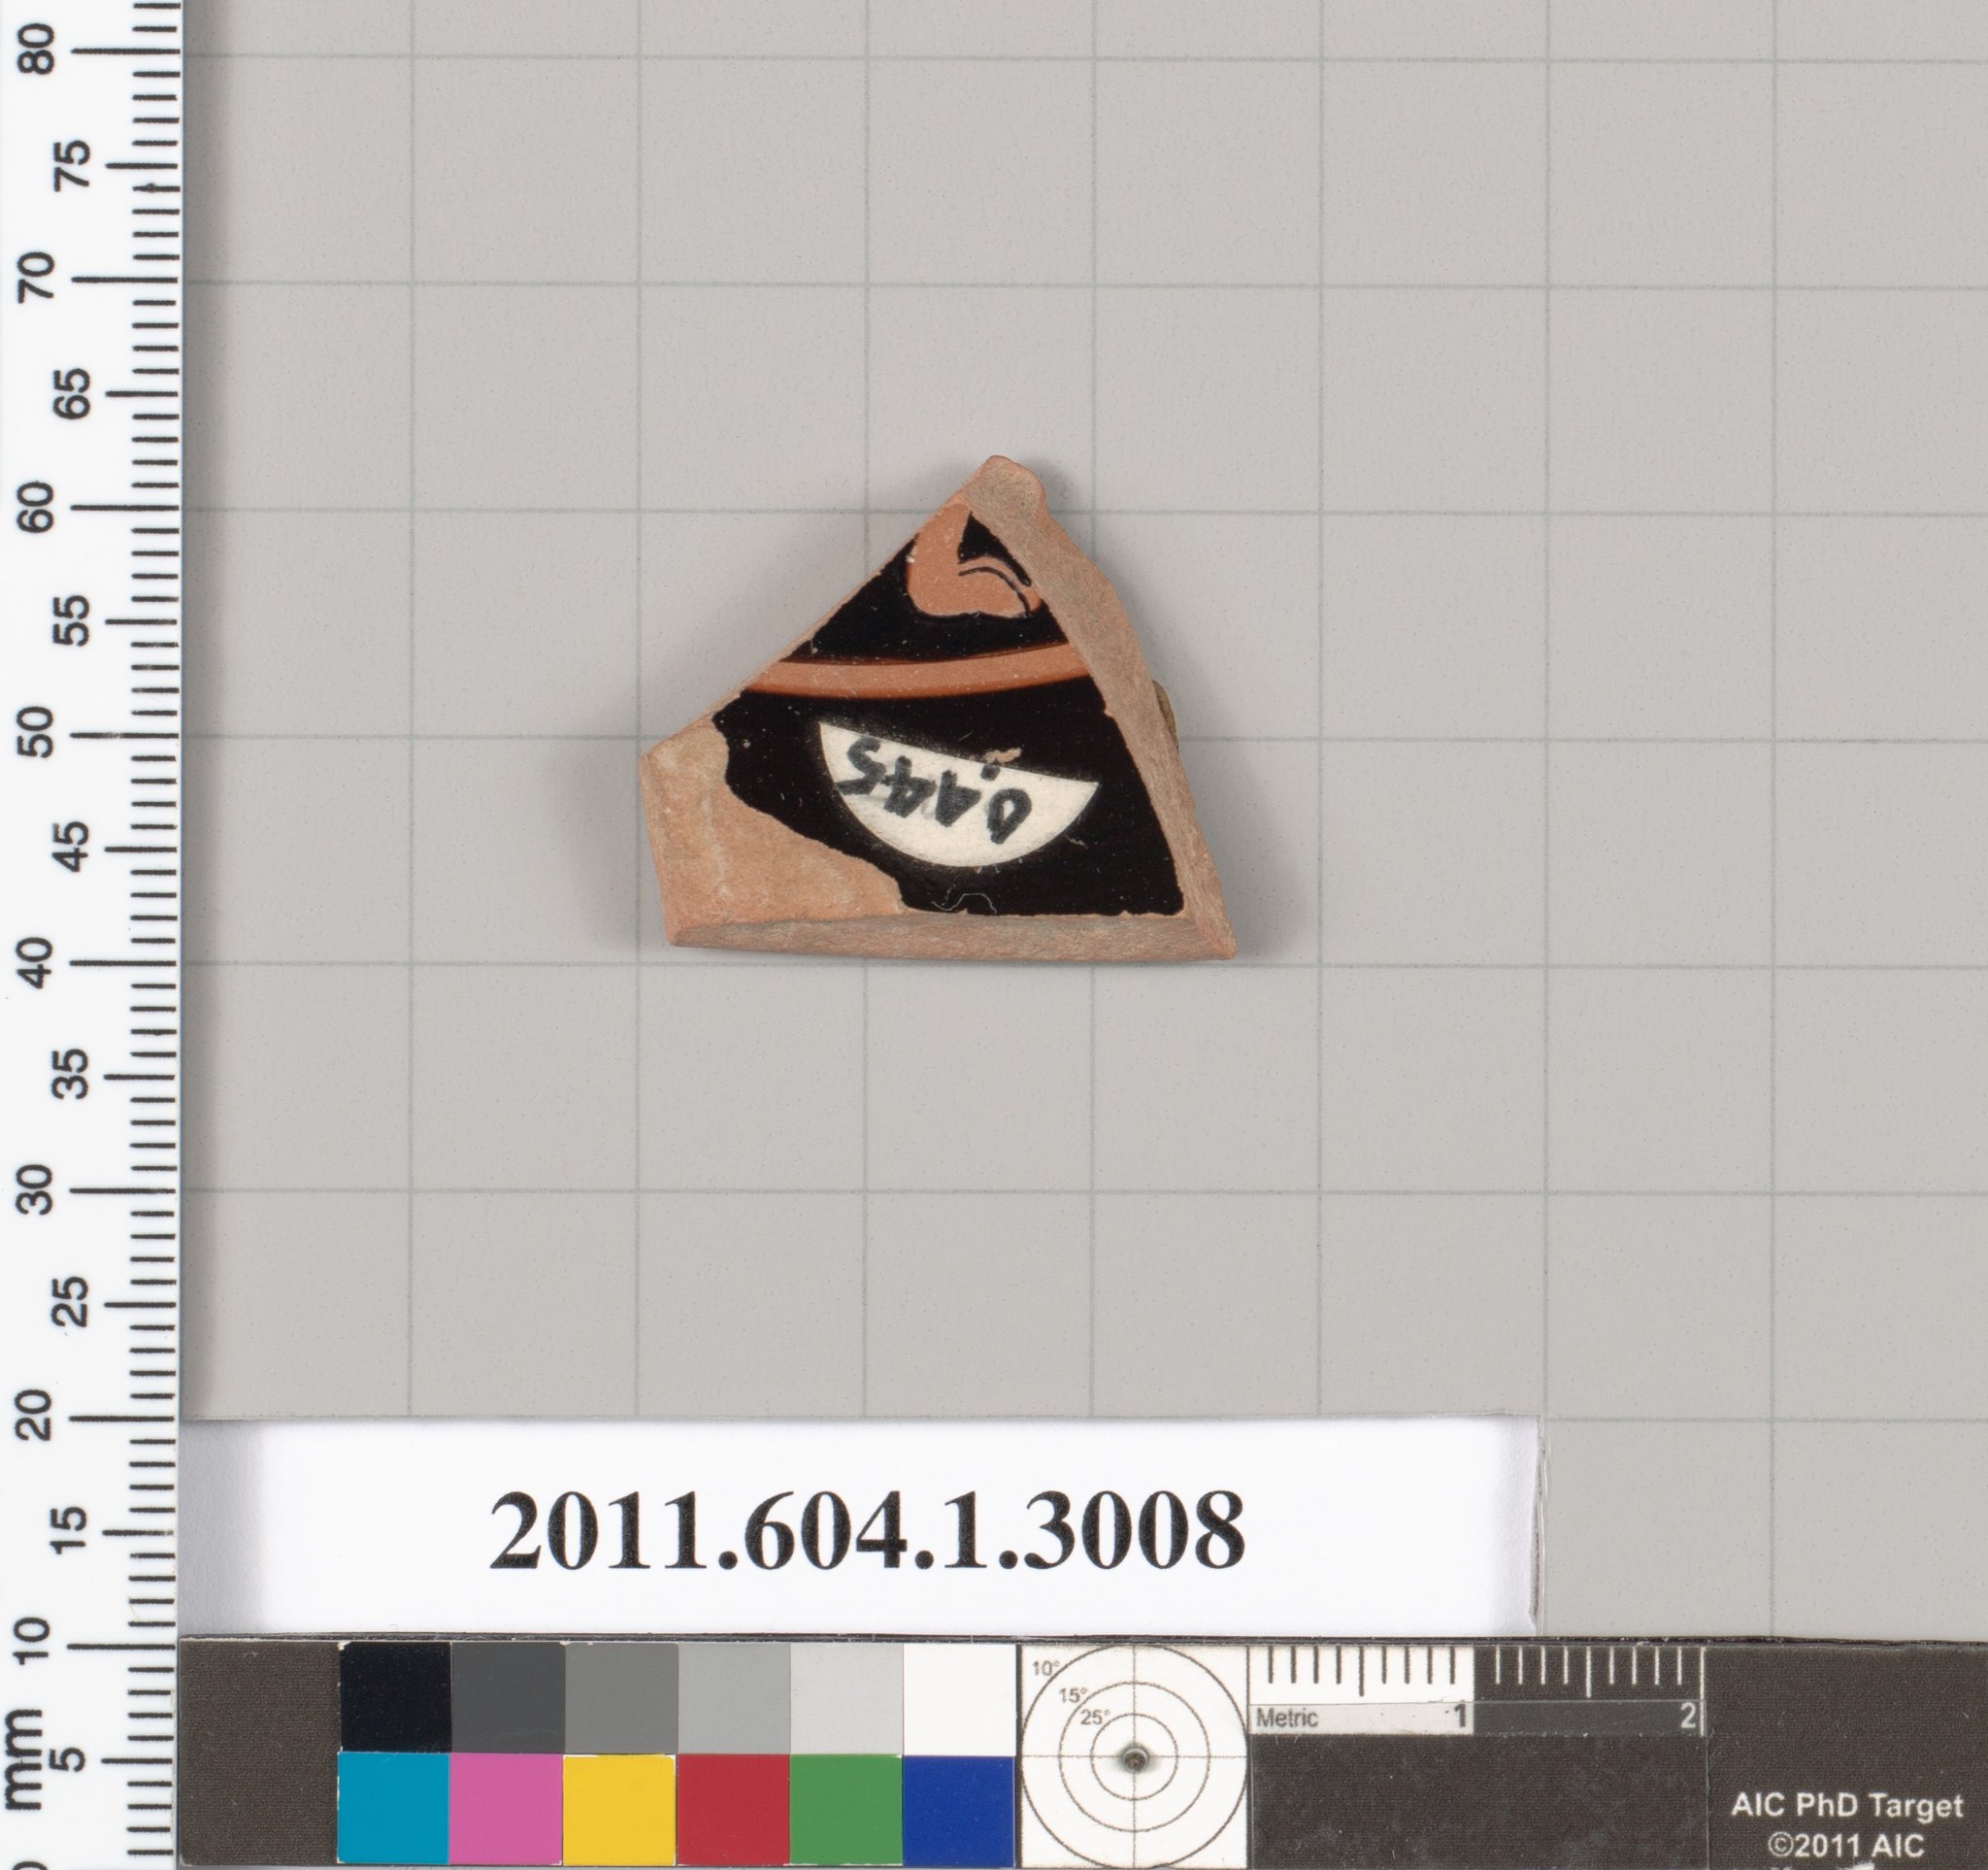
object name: kylix fragment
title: Terracotta fragment of a kylix (drinking cup)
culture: greek, attic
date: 510-490 BCE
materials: terracotta